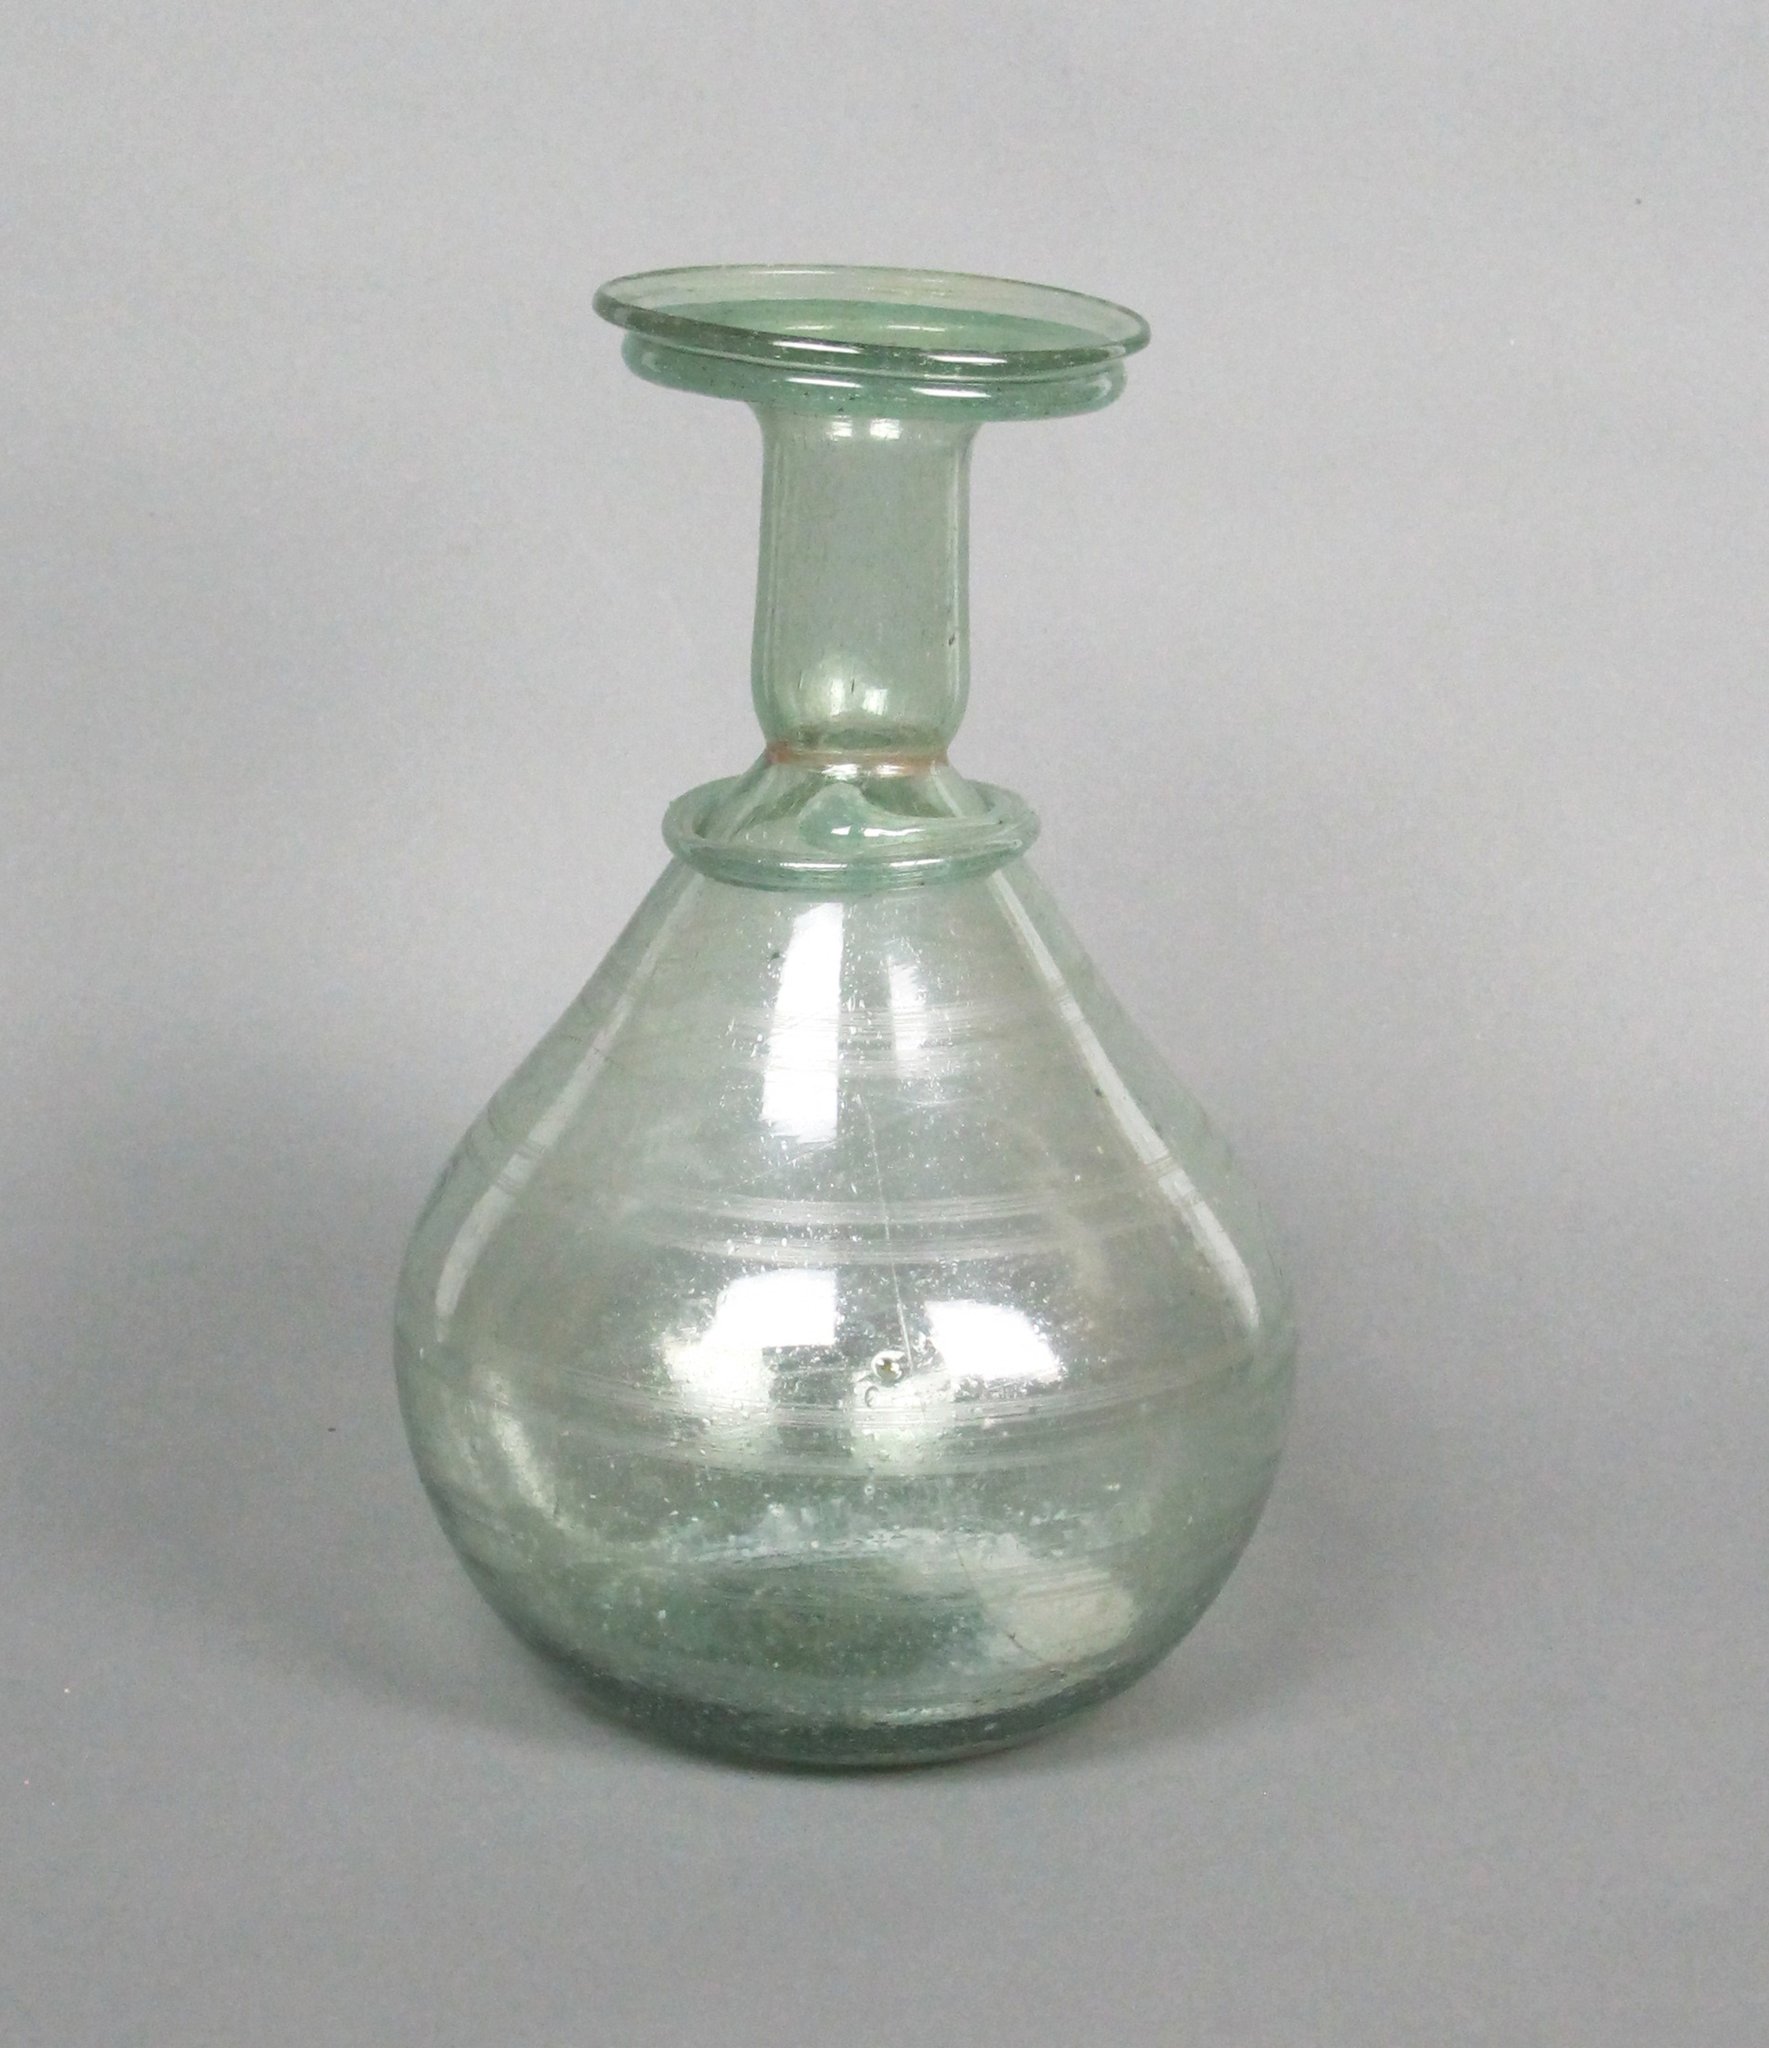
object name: bottle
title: Glass bottle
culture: roman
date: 301-400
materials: glass